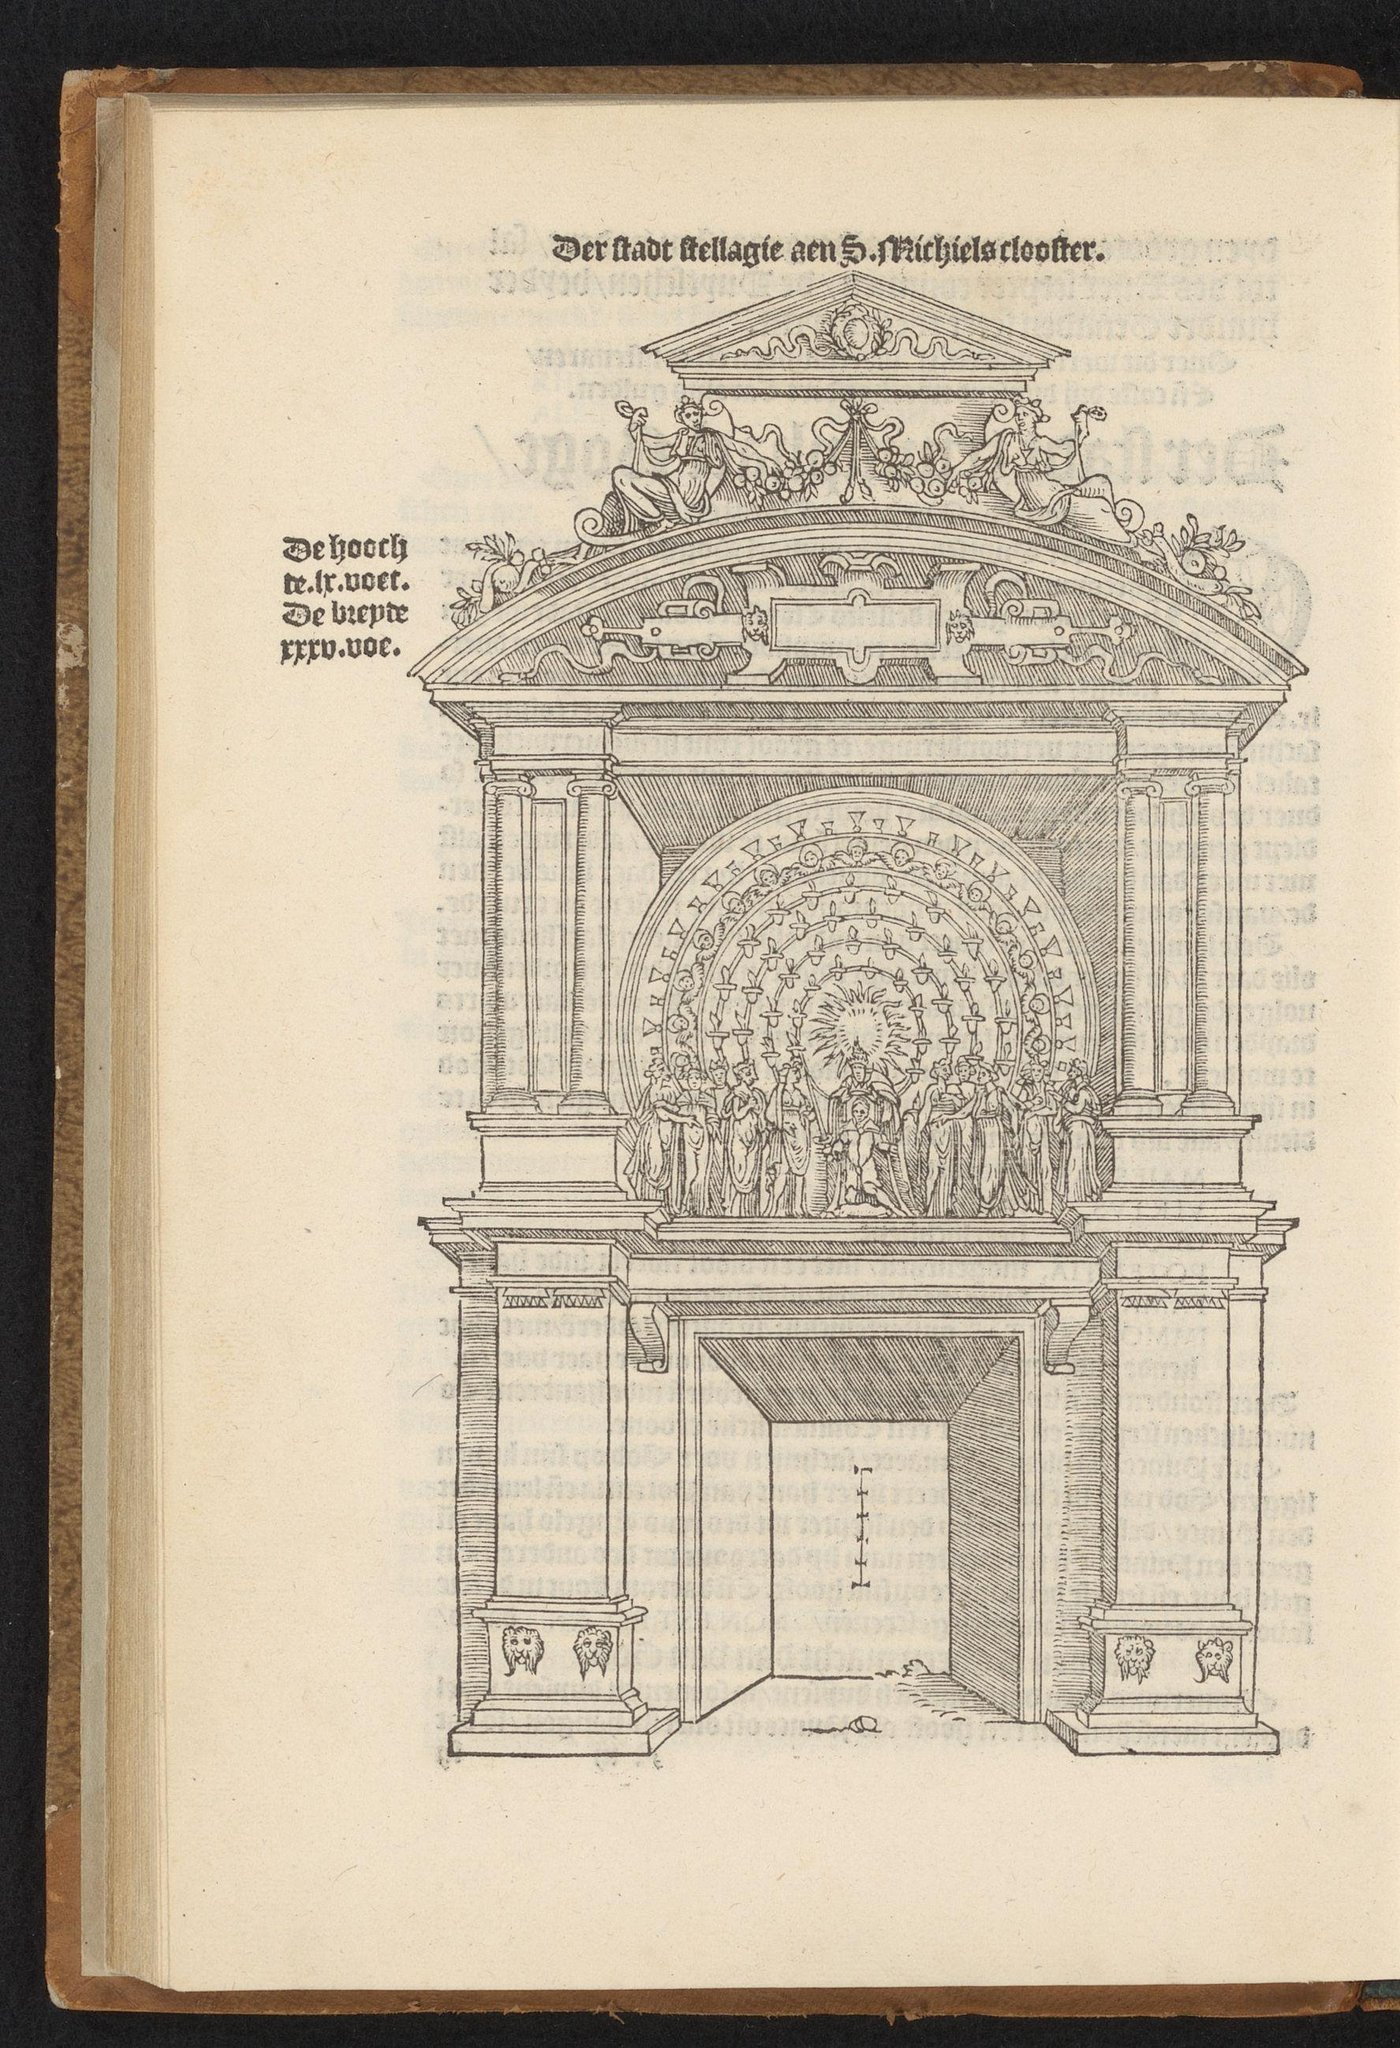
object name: print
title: De triomfboog van de stad waarin Filips door God gekroond wordt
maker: pieter coecke van aelst (i)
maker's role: draughtsman, print maker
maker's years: 1502-1550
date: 1549-1550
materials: paper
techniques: woodcut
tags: philip ii of spain, 'tableau vivant', triumphal arch, antwerp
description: Illustratie in de Nederlandse vertaling van de beschrijving van de intocht van Filips II in Antwerpen in 1549: De seer wonderlijcke schoone triumphelijcke incompst, van den hooghmogenden Prince Philips, Prince van Spaignen, Caroli des vijfden, Keysers sone : inde stadt van Antwerpen, Anno 1549. Tekst van Cornelius Grapheus, waarschijnlijk vertaald uit het Latijn door Gillis van Diest, opgedragen aan Filips II, uitgegeven met keizerlijke privilege door Pieter Coecke van Aelst, gedrukt door Gillis van Diest. Boek in de bibliotheek met signatuur: 325 B 12.